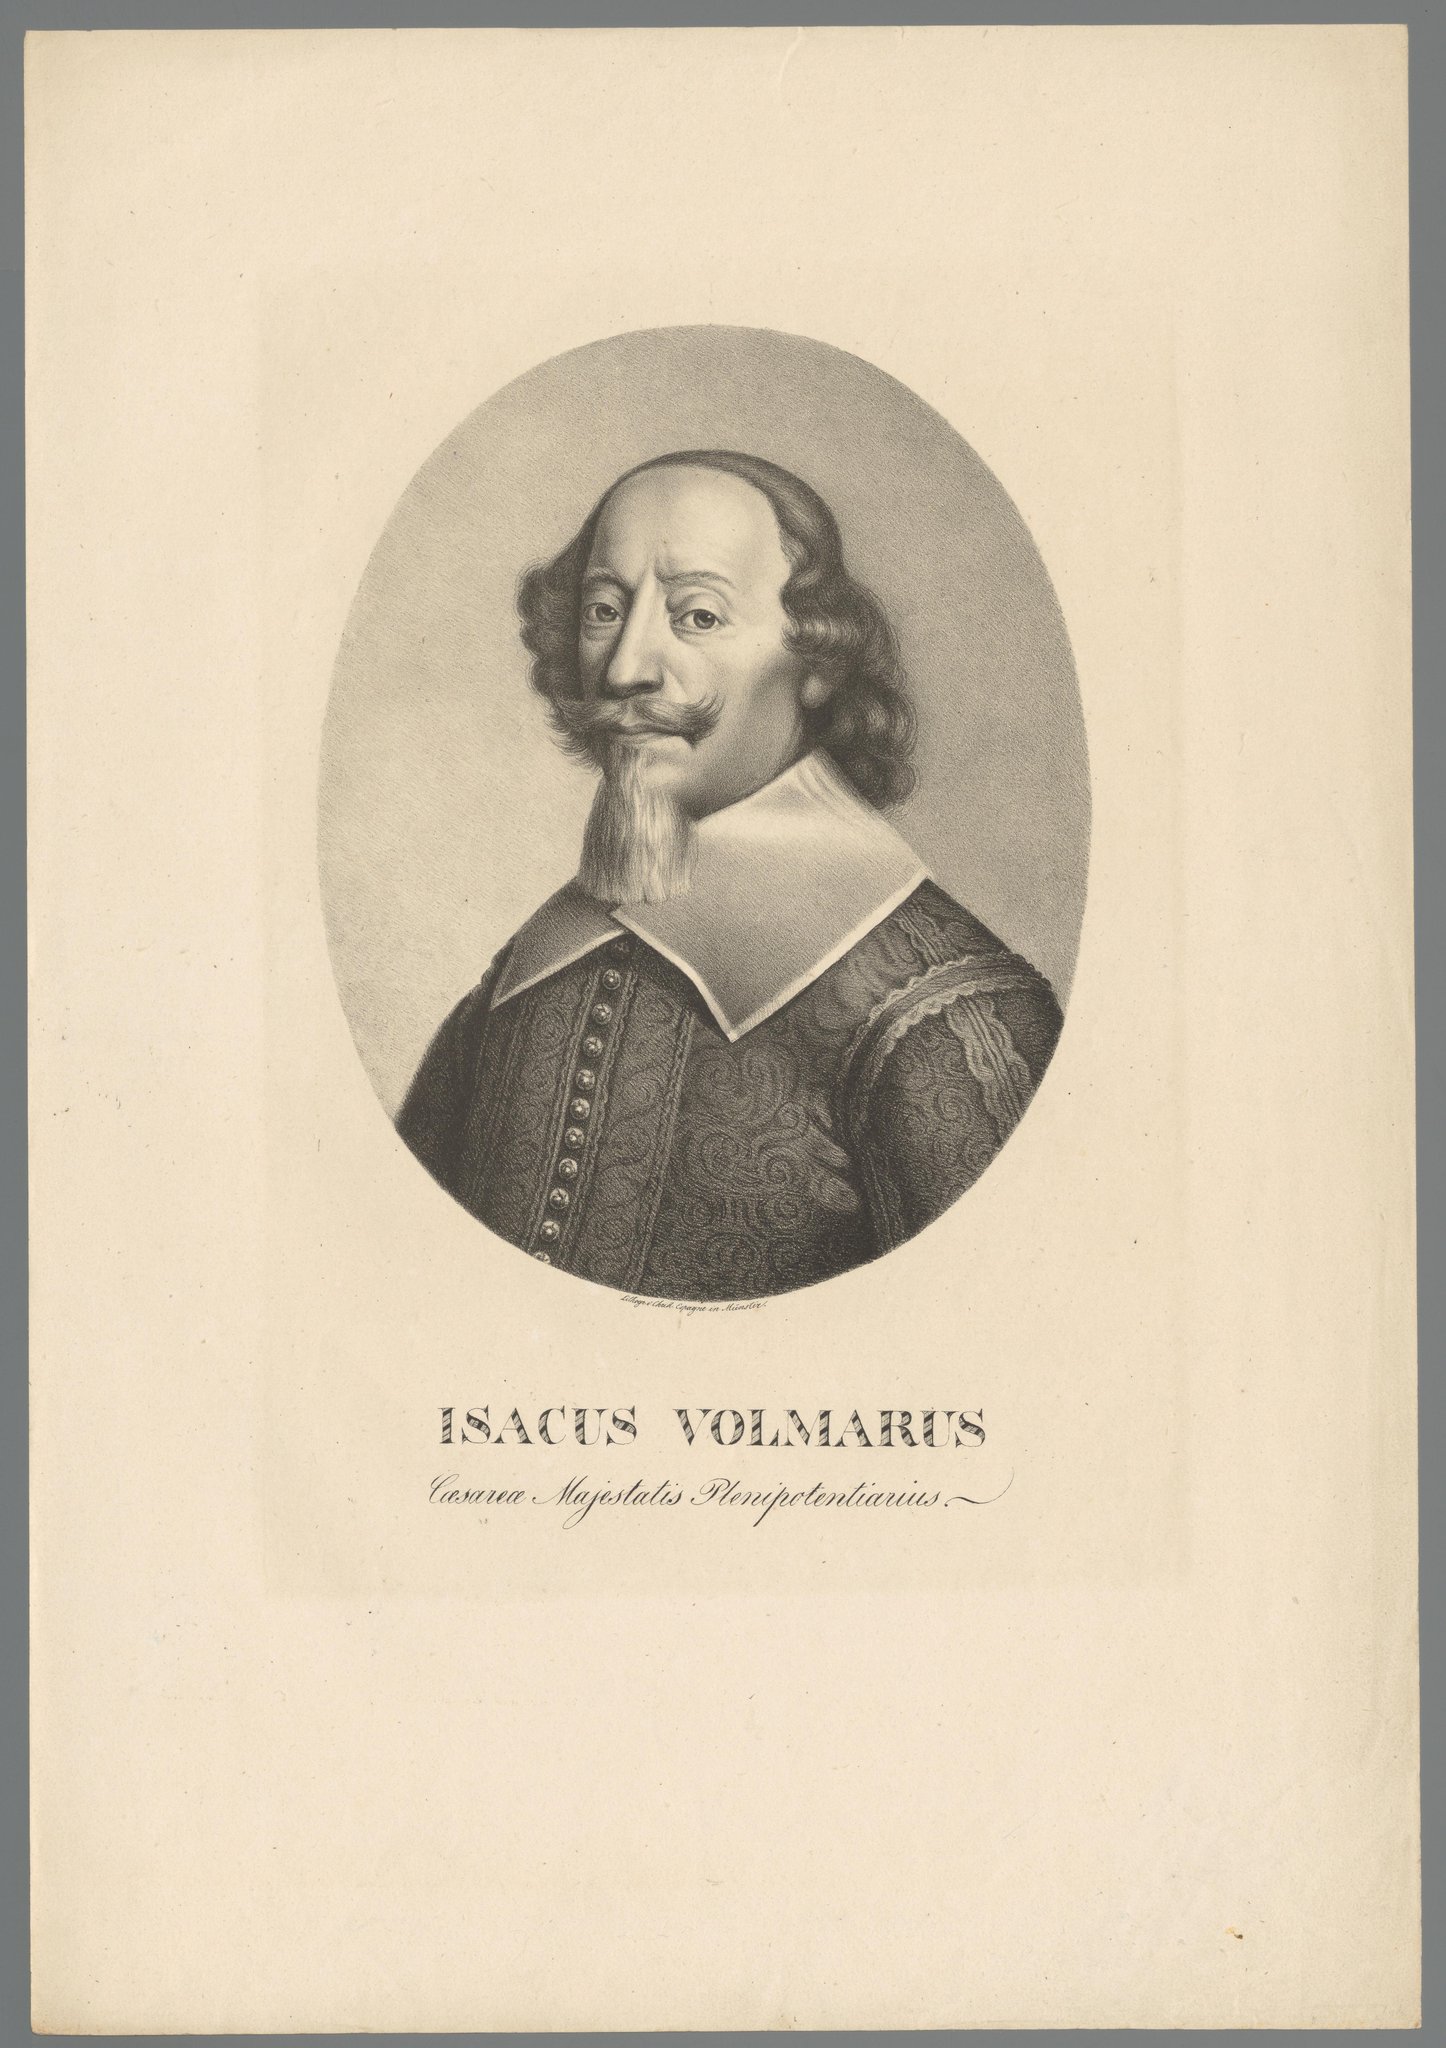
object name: print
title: Portret van Isaak Volmar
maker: christian espagne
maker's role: print maker, printer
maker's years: 1794-1838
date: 1824-1827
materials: paper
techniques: lithograph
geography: munster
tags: politician, adult man, historical persons, beard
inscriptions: collector's mark: Lugt 2228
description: Prent uit: Bildnisse der beim westfälischen Friedensschluß zu Münster und Osnabrück versammelt gewesenen Gesandten. Münster: Christian Espagne, [1824-1827]. Deze publicatie bevat een onbekend aantal lithografieën, die in afleveringen verschenen als illustratie bij de tekst.